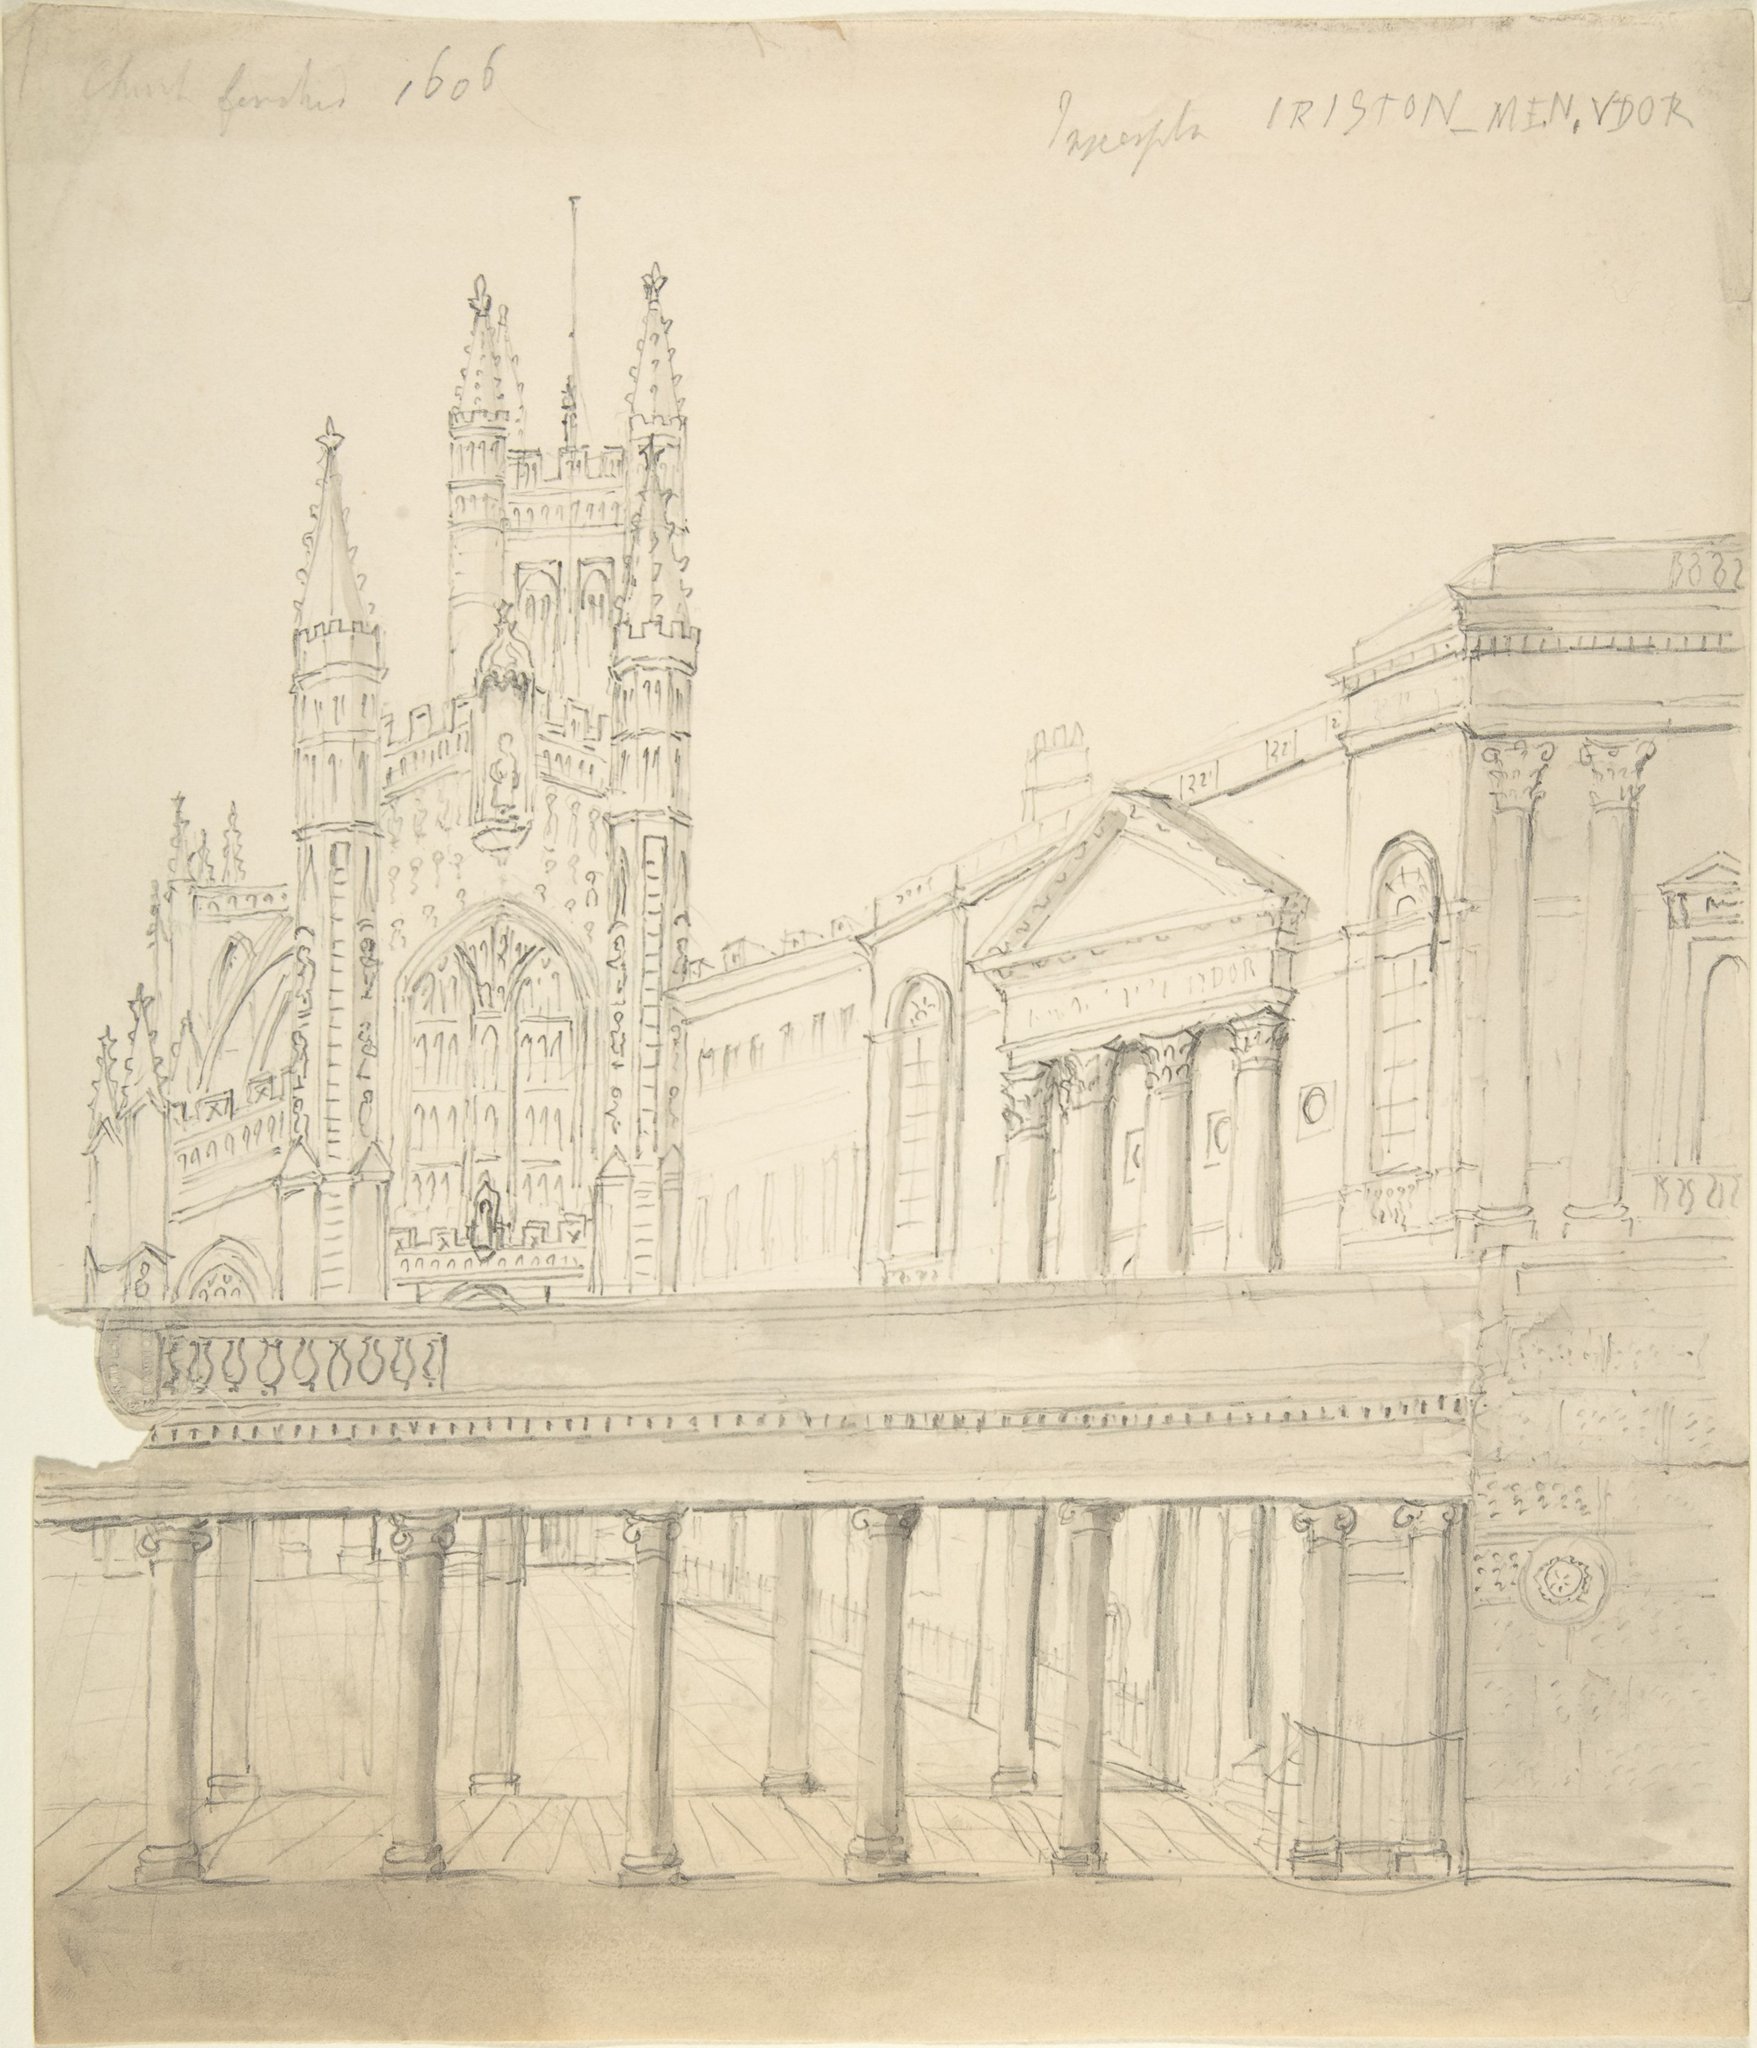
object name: drawing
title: View of the Abbey and Great Pump Room at Bath, Through the Colonnade Added by Thomas Baldwin, 1786-9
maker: anonymous, british, 19th century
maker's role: artist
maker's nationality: british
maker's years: 1800-1900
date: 1801-1900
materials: graphite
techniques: brush, wash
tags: buildings,churches